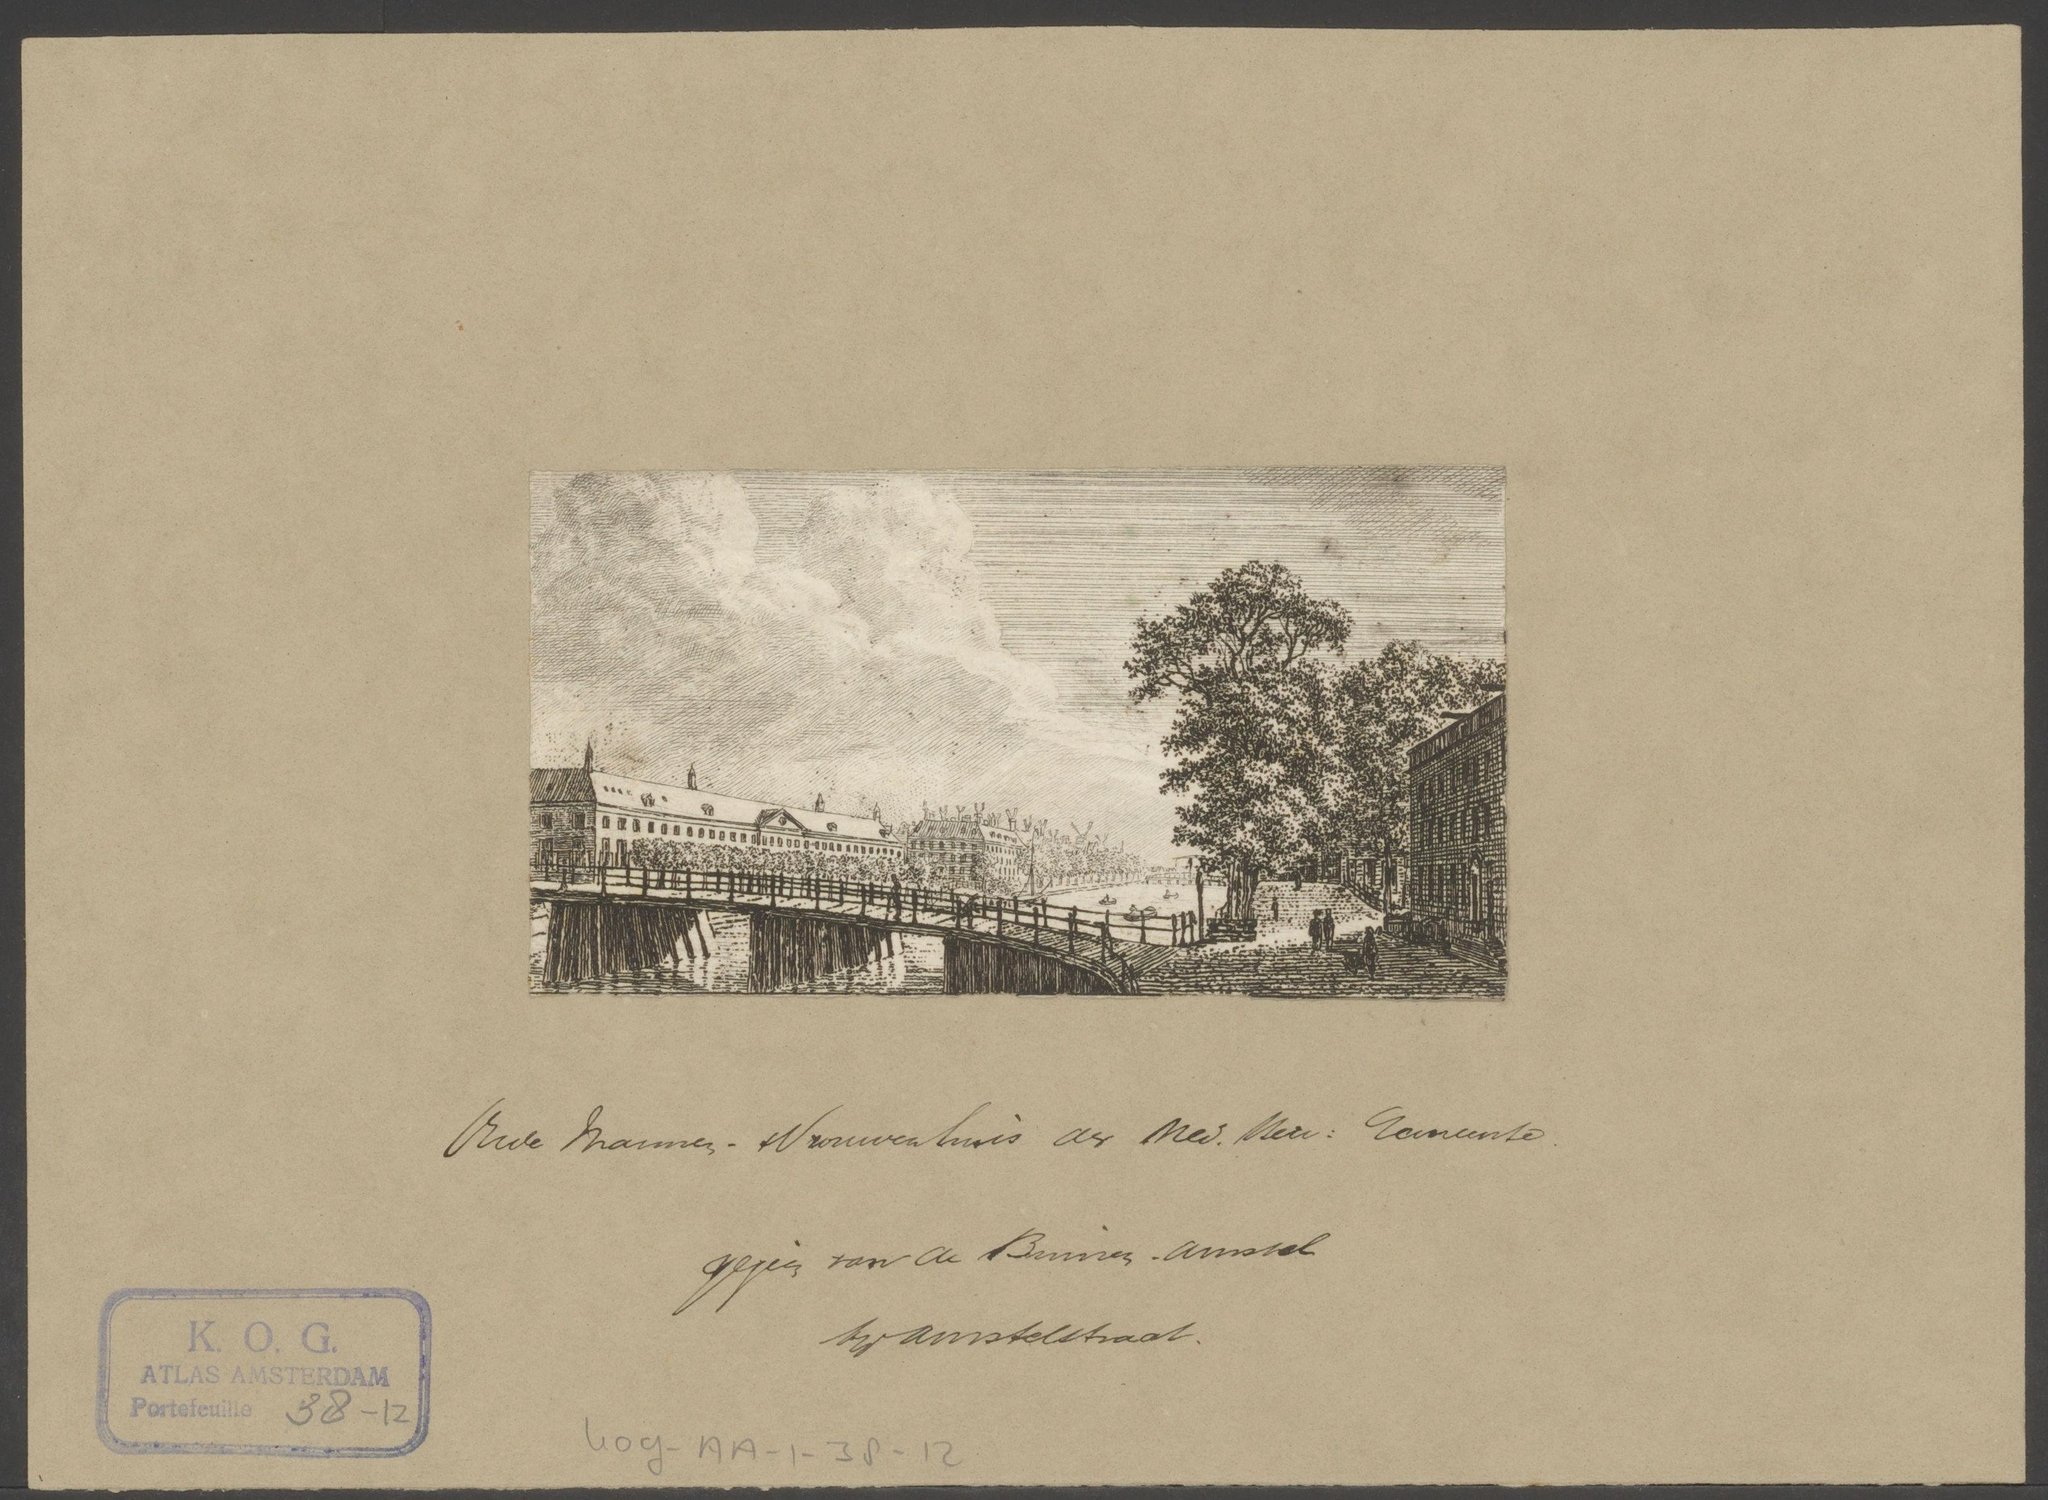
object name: print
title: Gezicht op het Diaconie Oude Vrouwen- en Mannenhuis en de Blauwbrug te Amsterdam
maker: Anonymous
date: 1701-1800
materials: paper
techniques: etching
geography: northern netherlands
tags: bridge in city across river, canal, etc. (+ city(-scape) with figures, staffage), canals, waters (in city) (+ city(-scape) with figures, staffage), old-people's home, street (+ city(-scape) with figures, staffage)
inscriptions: collector's mark: Lugt 1641b, number: ‘No. 1’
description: Onderwerpsrubriek binnen de Atlas Amsterdam: Armwezen en liefdadige instellingen: II. Kerkelijke inrichtingen: Diaconie Oude Mannen- en Vrouwenhuis der Ned. Herv. Gem.